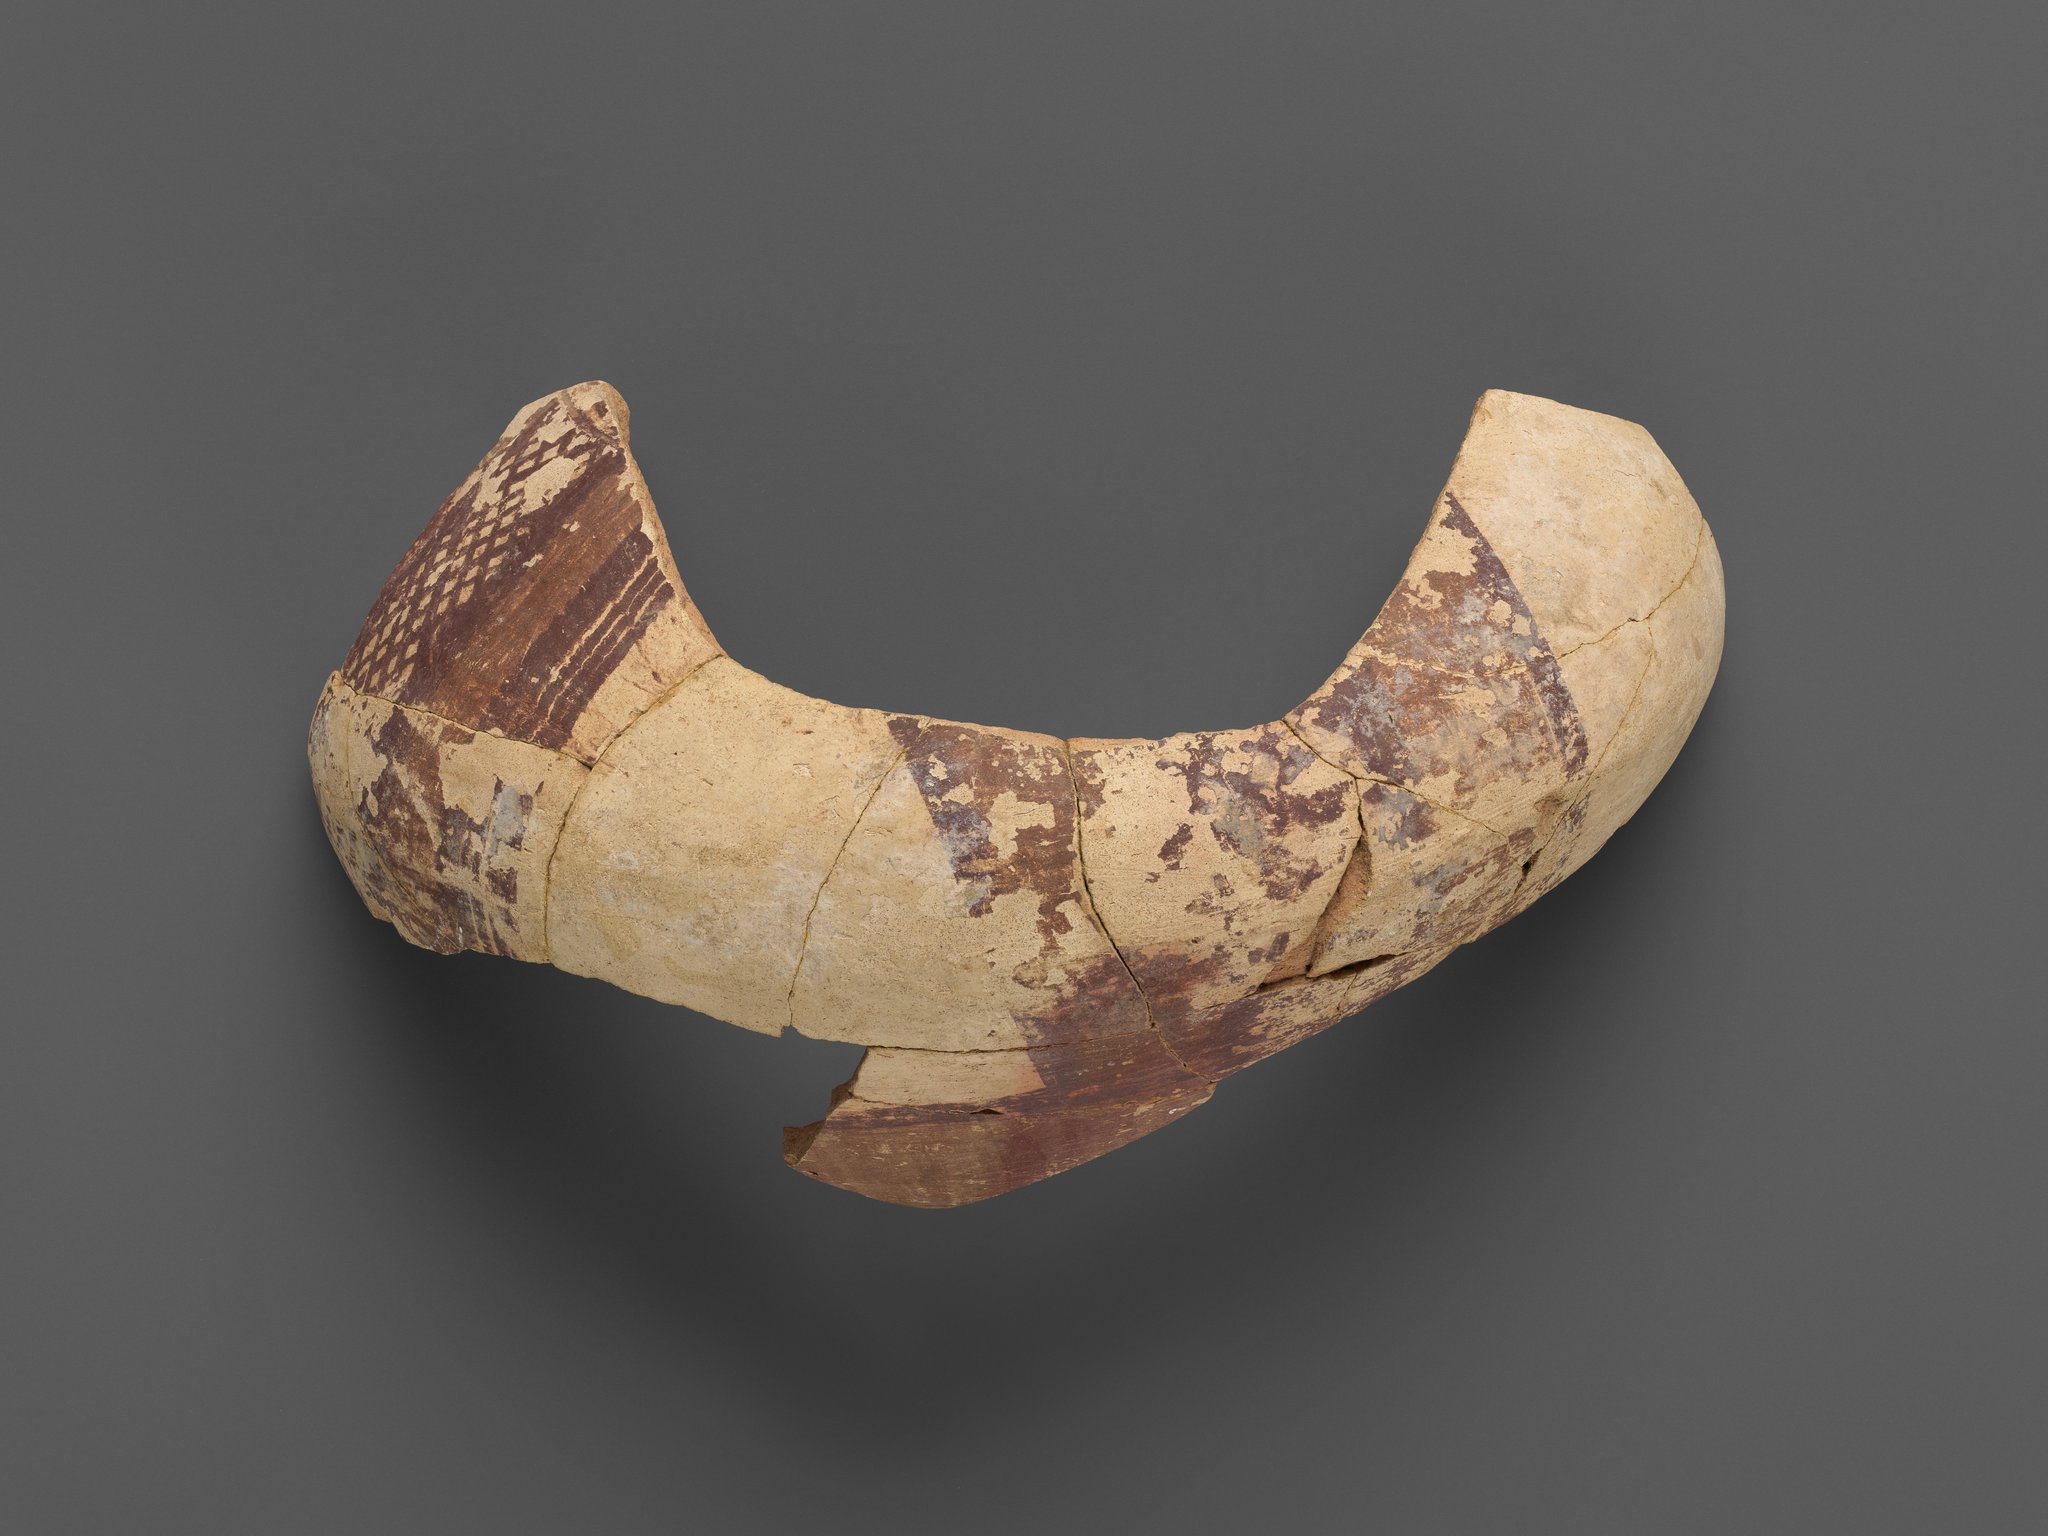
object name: jar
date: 3100-2900 BCE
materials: ceramic, paint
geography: mesopotamia